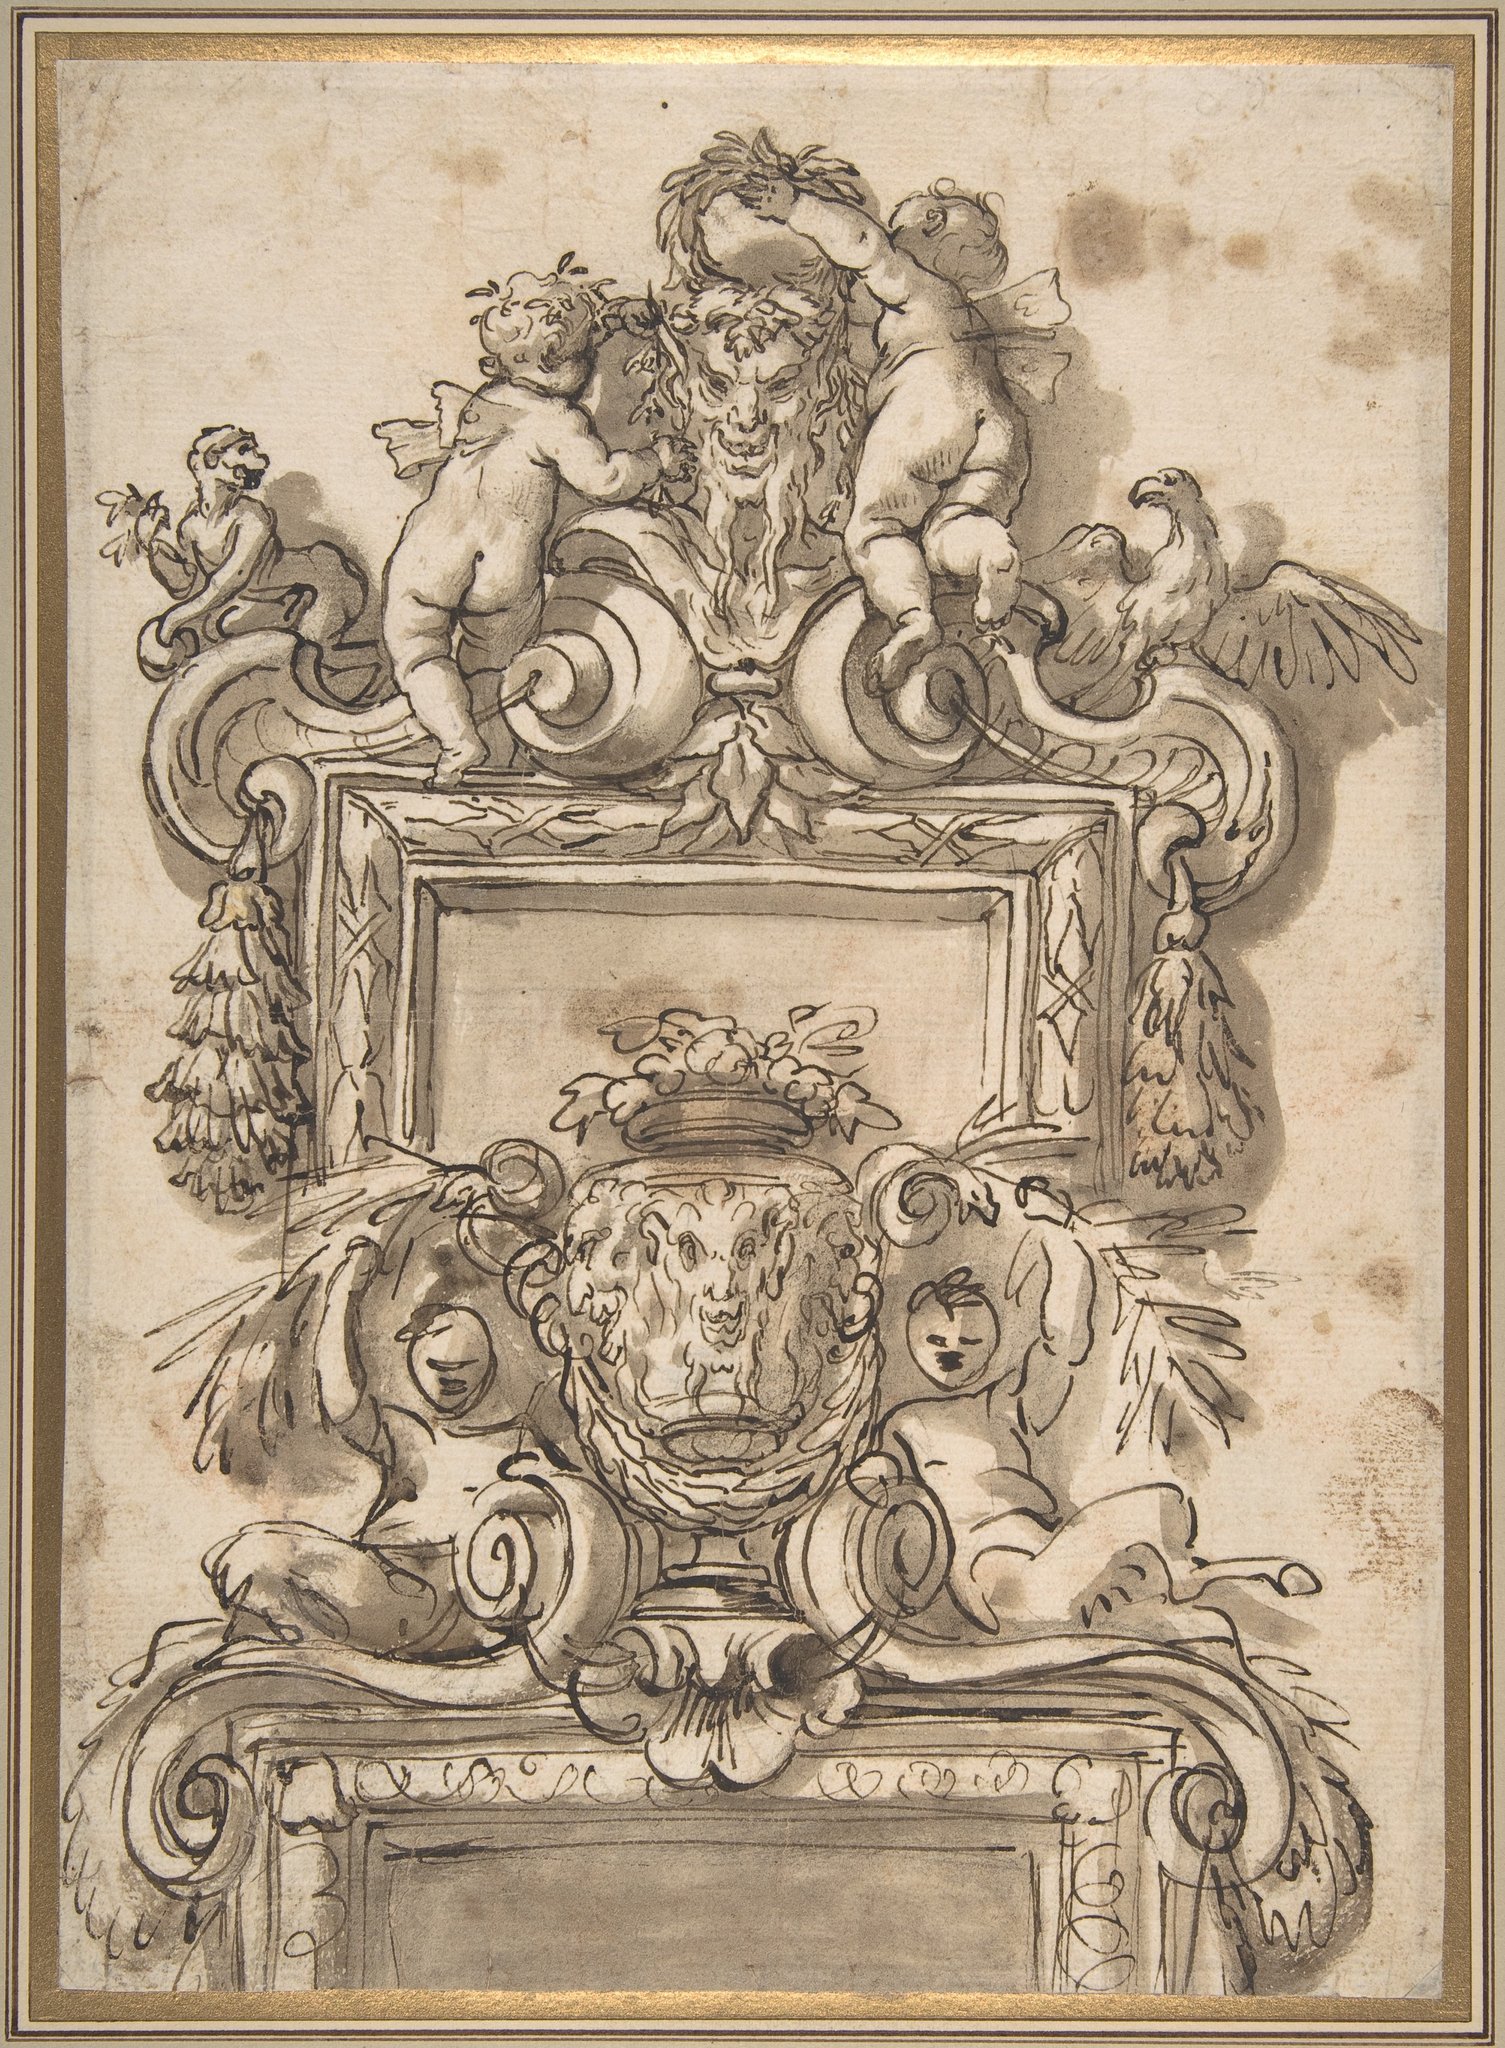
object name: drawing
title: Design for an Overdoor Decoration (recto); Rinceaux (verso)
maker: gregorio de' ferrari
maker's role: artist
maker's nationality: italian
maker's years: 1647-1726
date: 1670-1690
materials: chalk, ink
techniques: brush, pen, wash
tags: satyrs